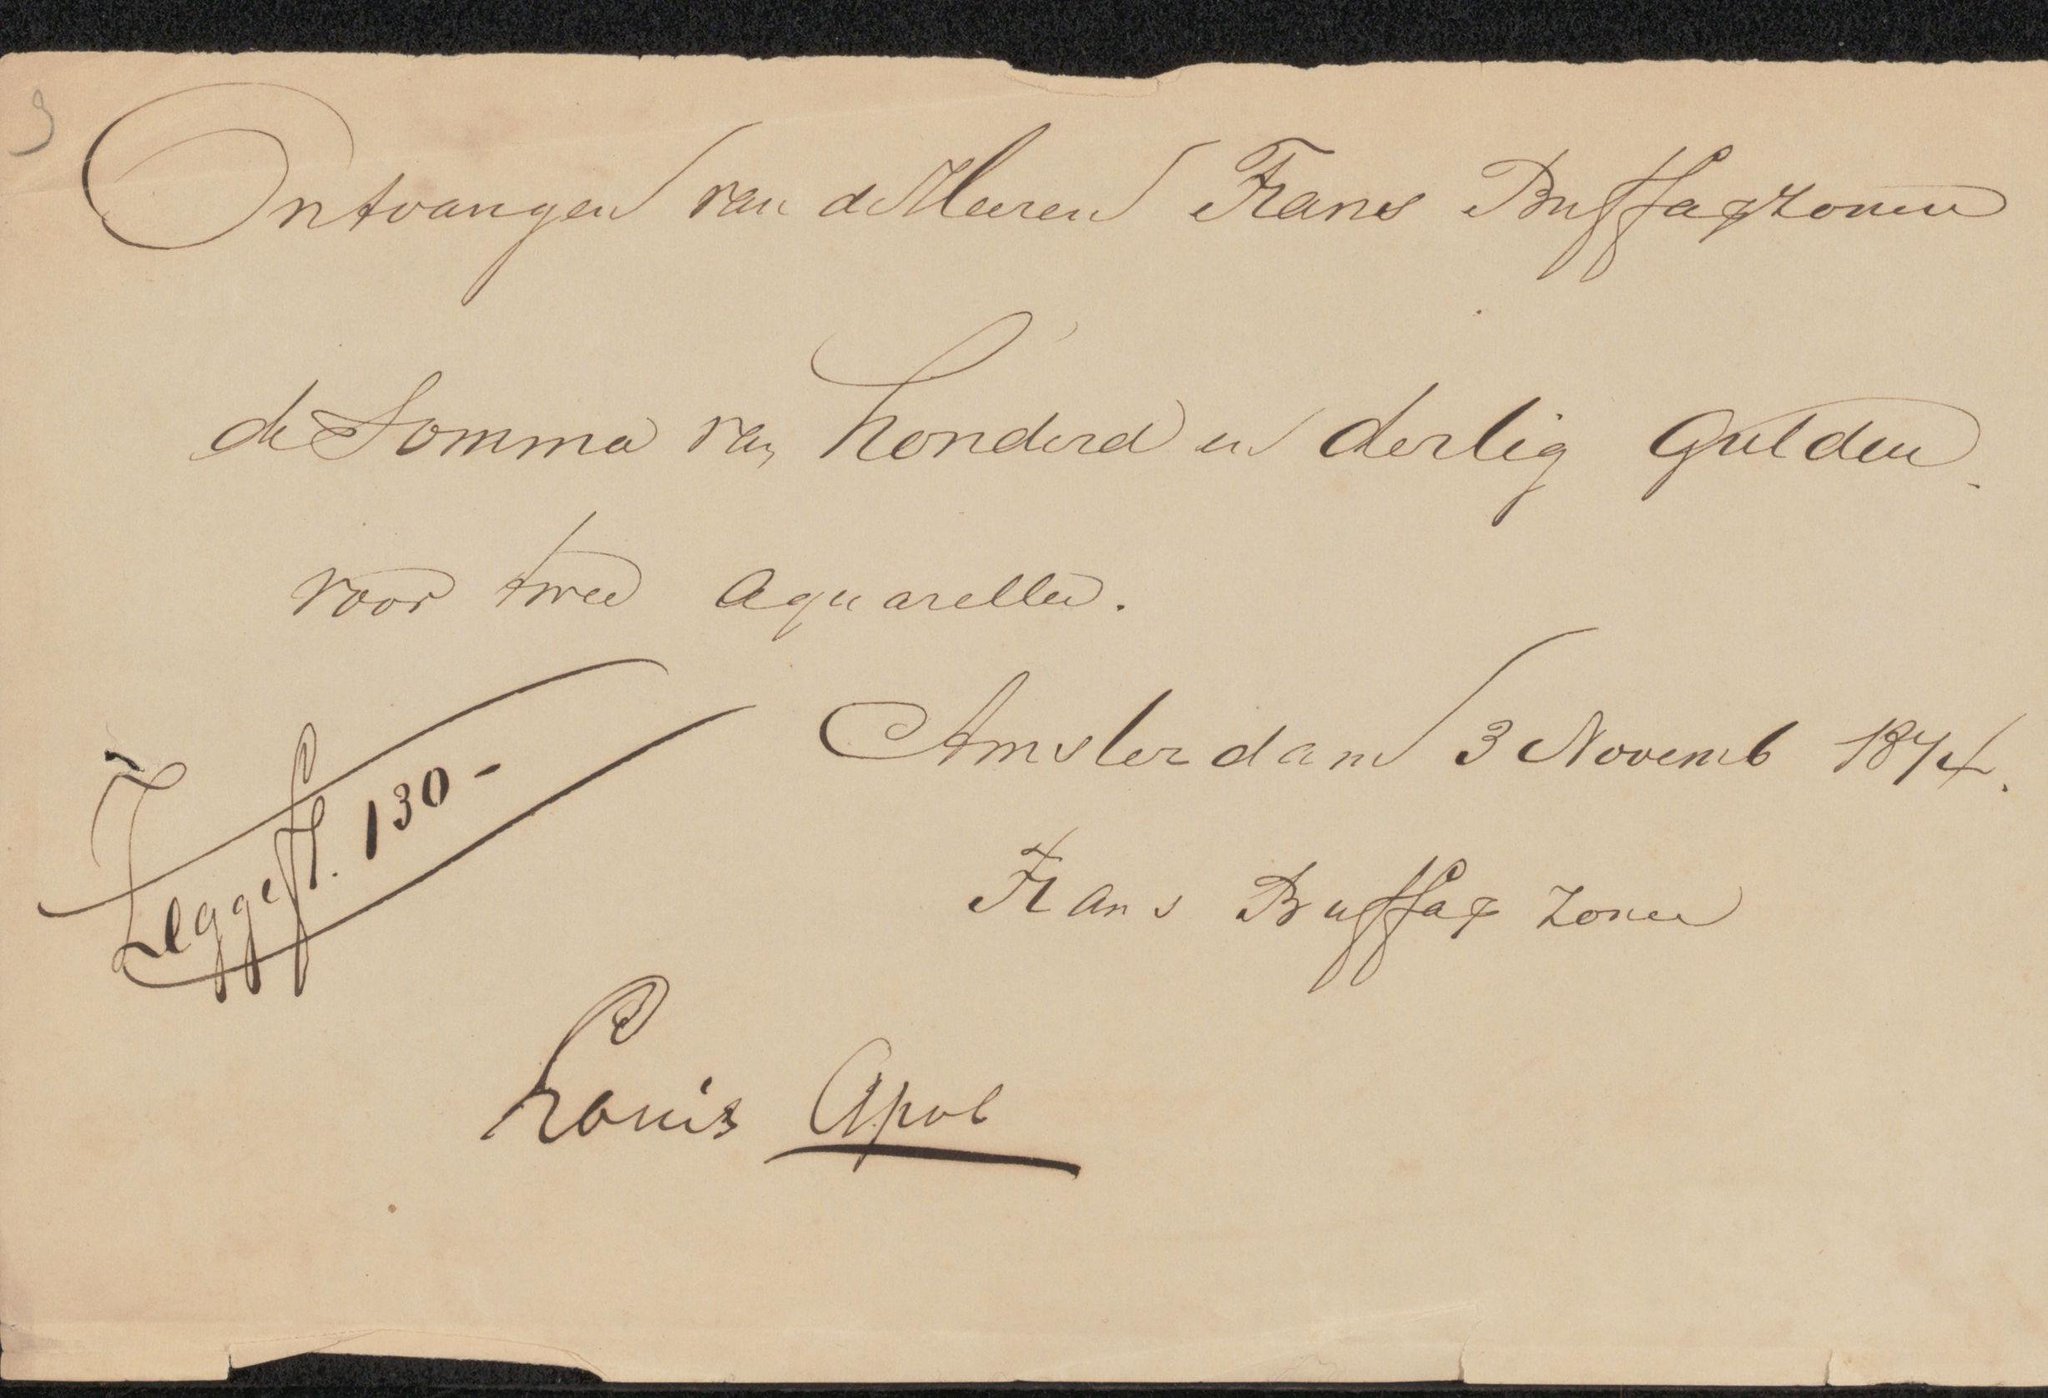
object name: ontvangstbewijs, kwitantie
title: Ontvangstbewijs aan Louis Apol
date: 1874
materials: ink, paper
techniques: pen, writing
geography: amsterdam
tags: painter, print maker, draughtsman, louis apol, drawing, money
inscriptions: collector's mark: Lugt 2233